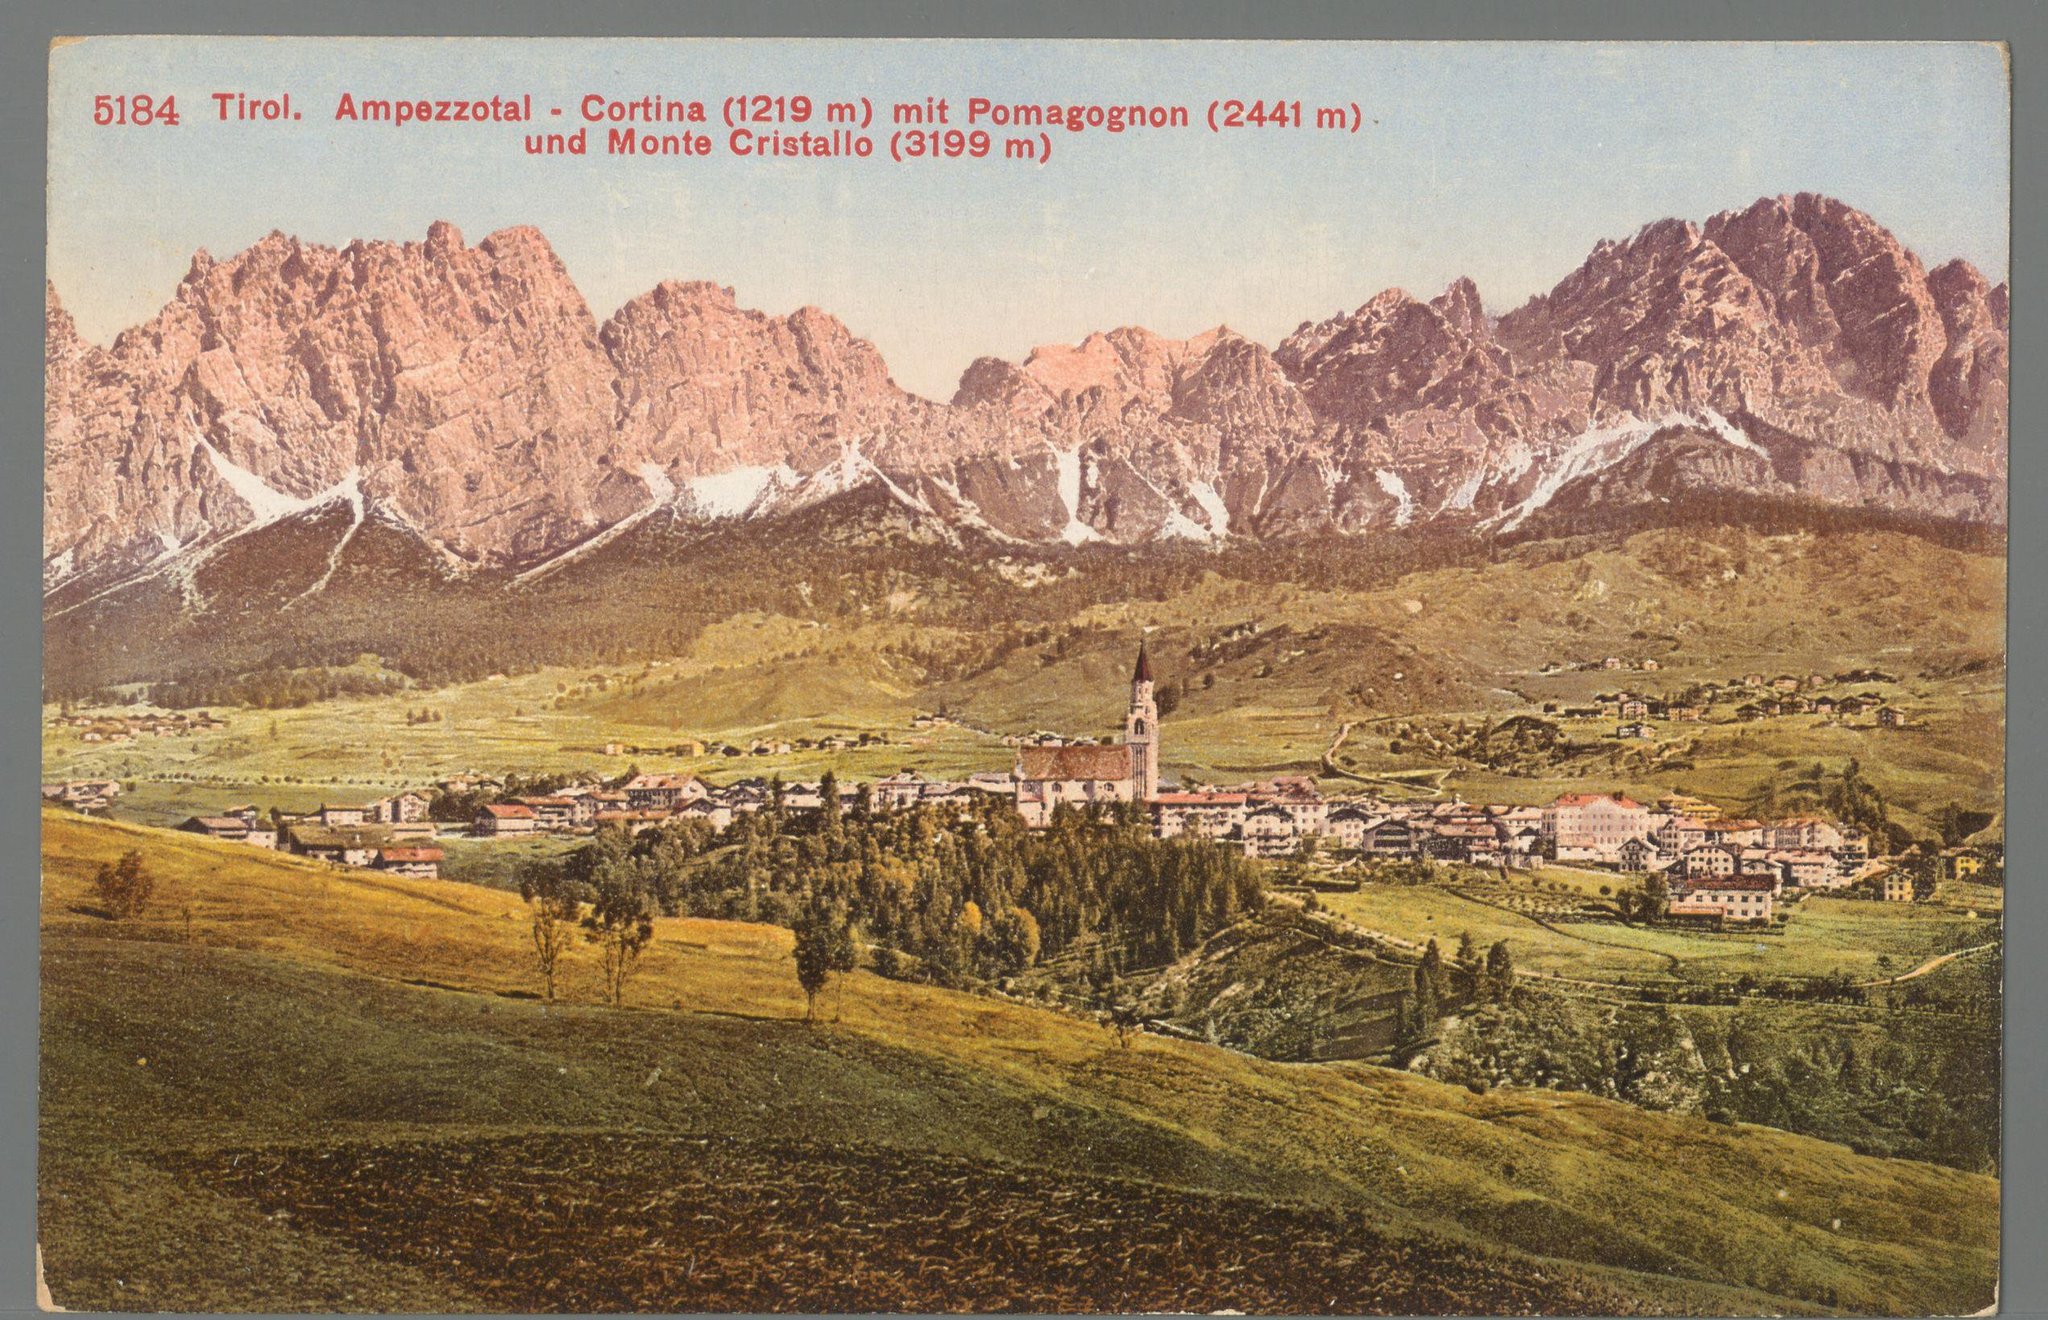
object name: photomechanical print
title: Tirol. Ampezzotal. Cortina (1219 m) mit Pomagognon (2441m) und Monte Cristallo (3199 m)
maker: Anonymous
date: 1905-1930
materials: cardboard, photographic process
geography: zurich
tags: church (exterior), prospect of city, town panorama, silhouette of city, mountains